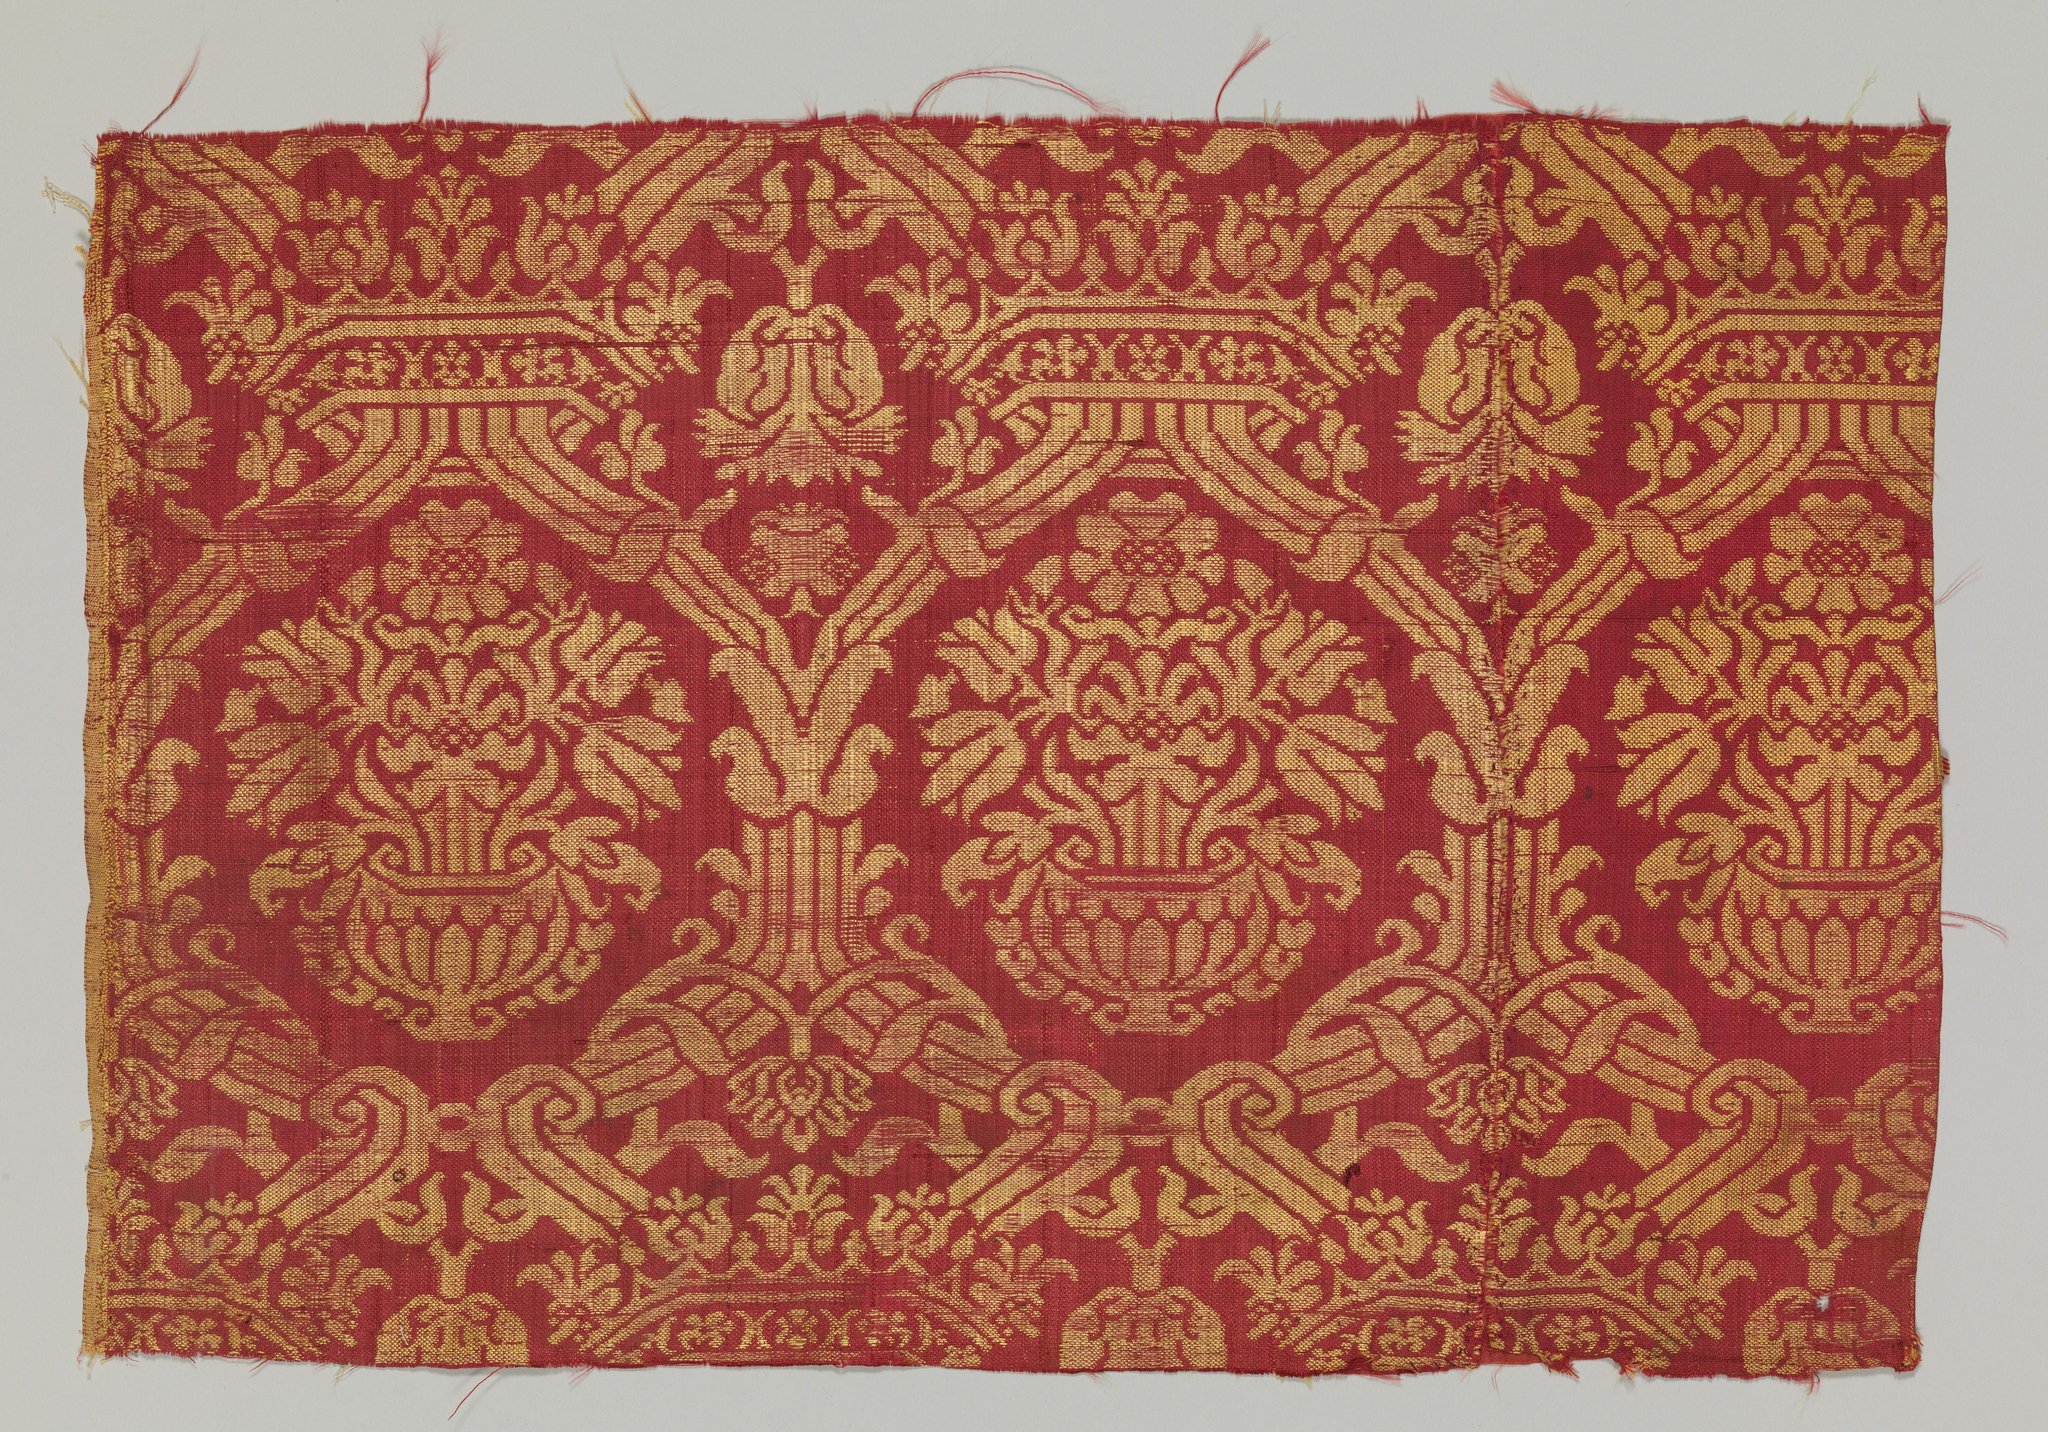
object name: piece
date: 1501-1600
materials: silk